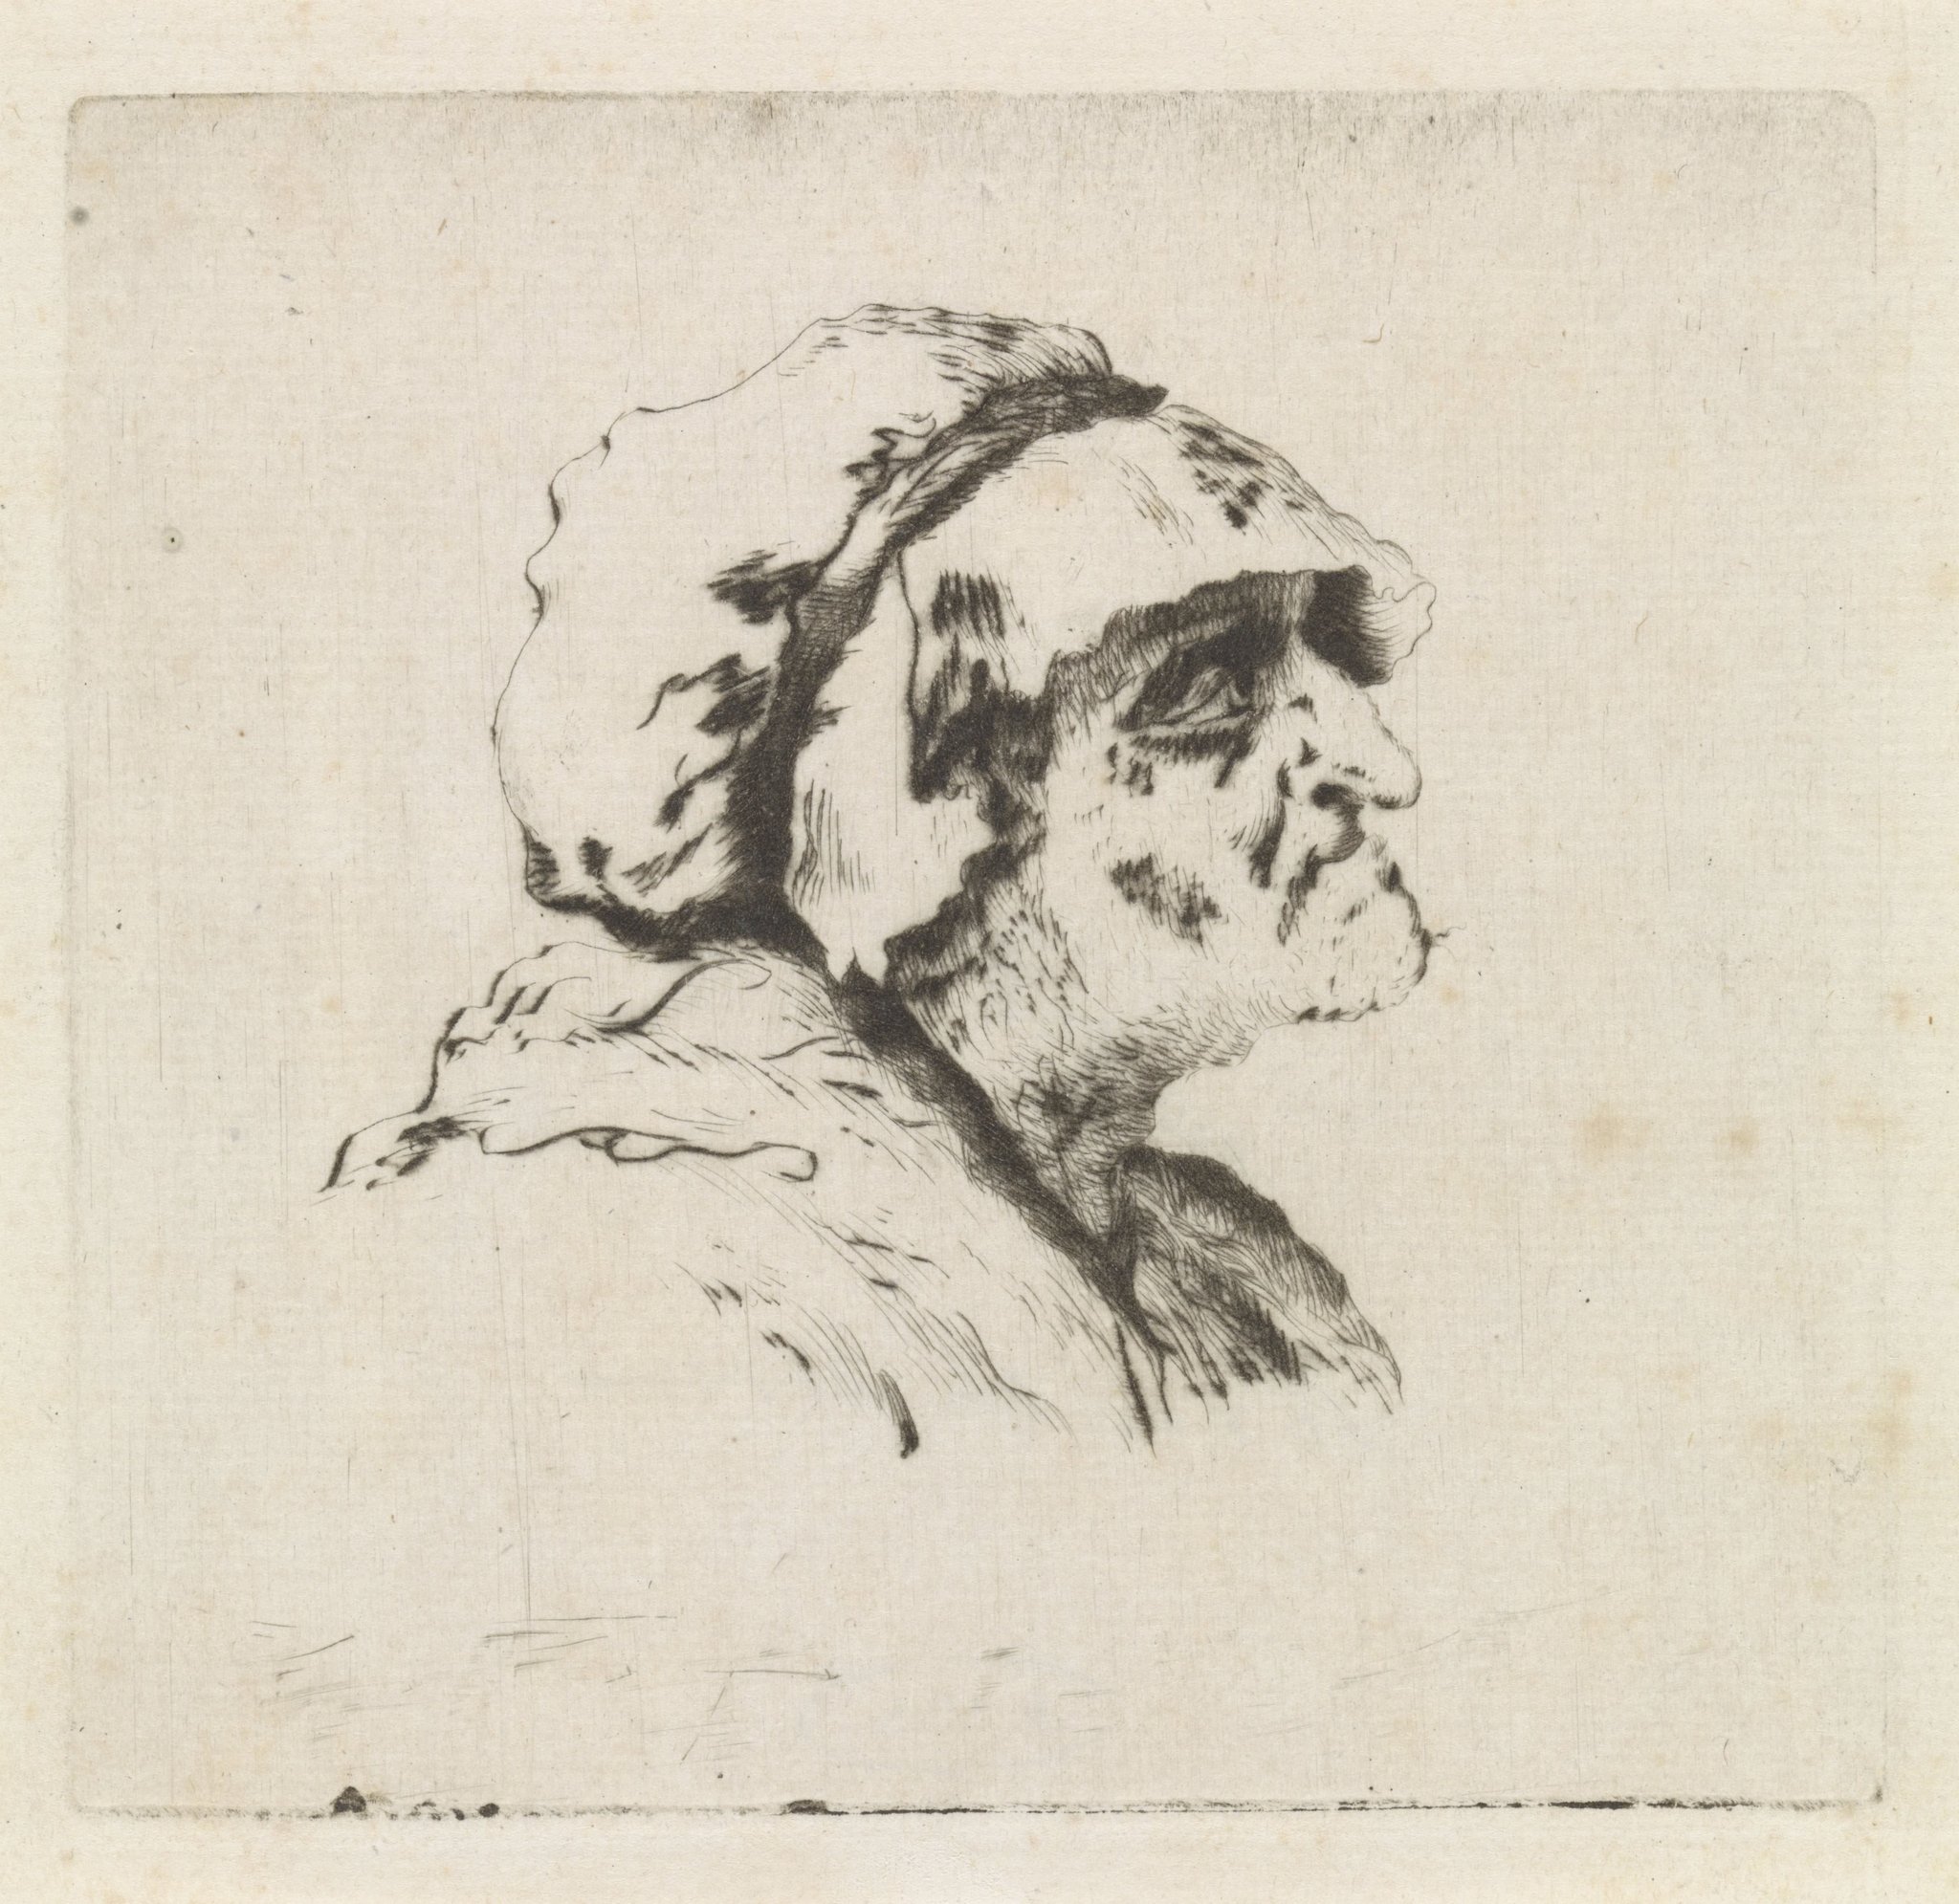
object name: print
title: Oude vrouw, naar rechts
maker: hendrik van maarseveen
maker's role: draughtsman, print maker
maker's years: -1792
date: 1741-1792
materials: paper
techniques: drypoint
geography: amsterdam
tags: old woman (+ sideview, profile)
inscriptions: collector's mark: Lugt 2228